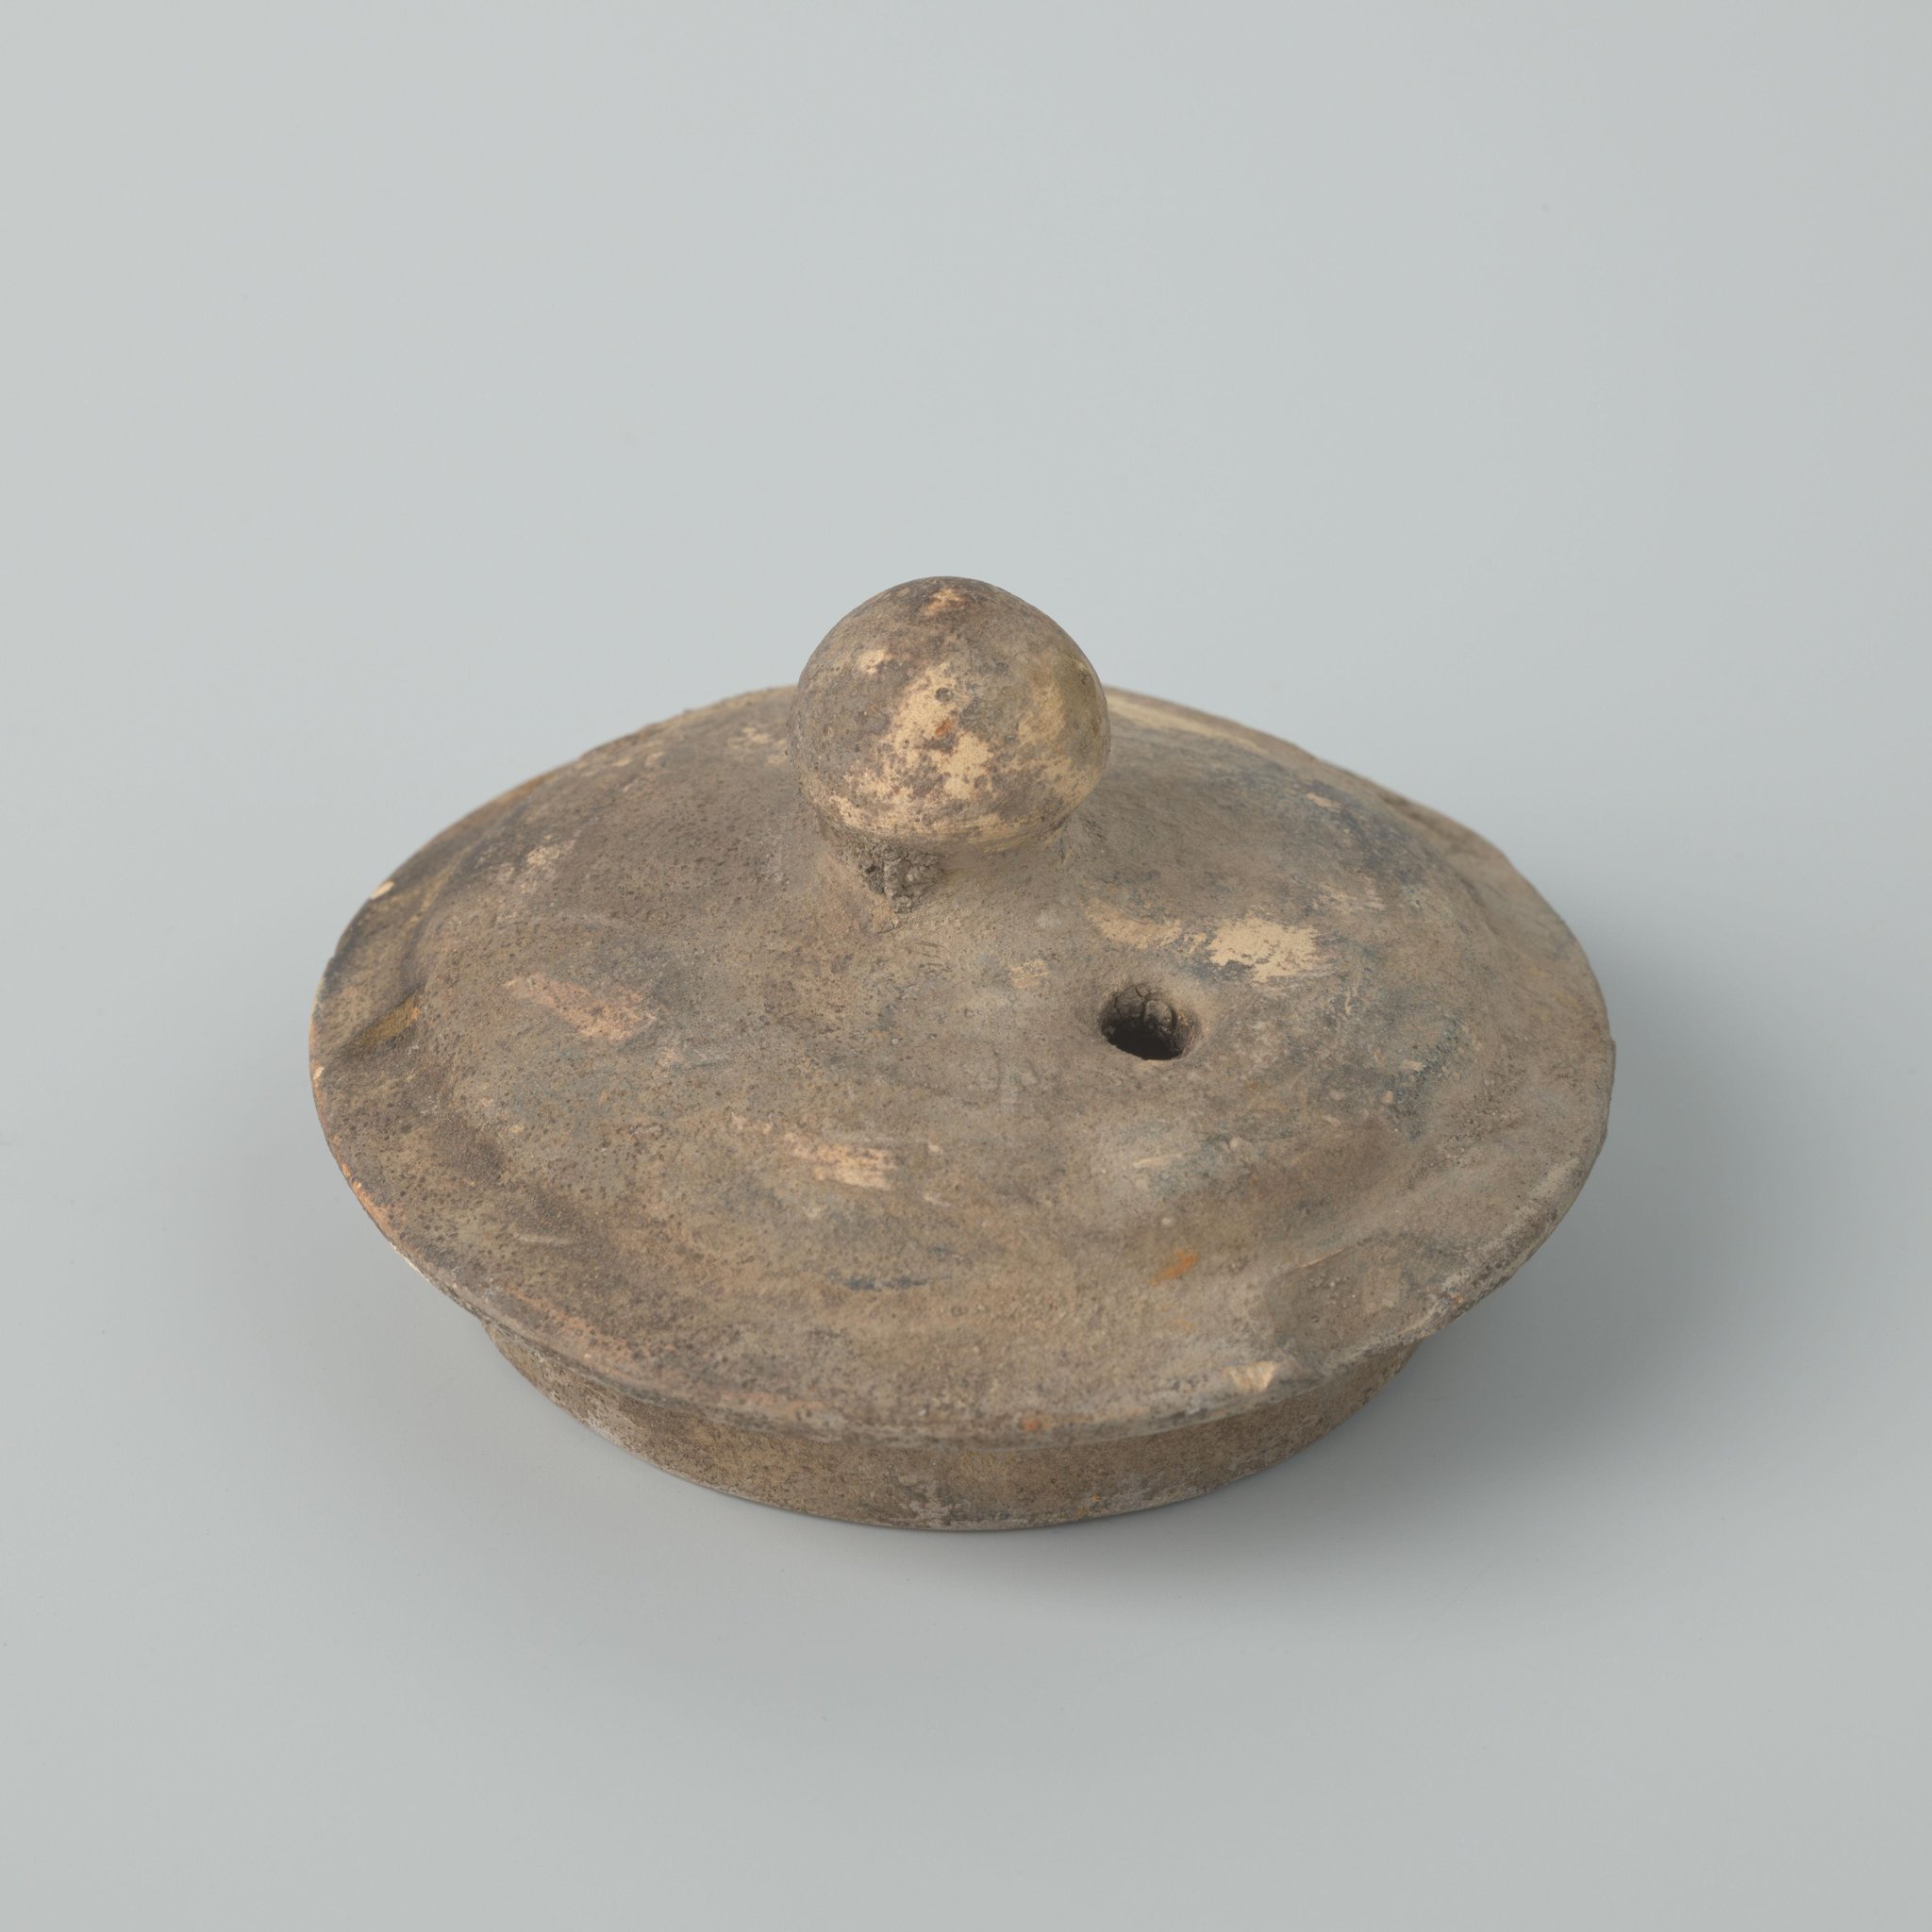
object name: lid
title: Deksel van een theepot (De Caluwe bakafval)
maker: jacobus de caluwe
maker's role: plateelbakkerij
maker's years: -1730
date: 1700-1725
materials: earthenware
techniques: firing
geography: delft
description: Toegeschreven aan Jacobus de Caluwe, omdat dit voorwerp samen met gemerkte stukken (‘Jacobus De Caluwe’ en rennend hert) gevonden is op de plaats waar zich De Caluwes tweede werkplaats bevond. Er is een duidelijke stilistische overeenkomst tussen de gemerkte en niet gemerkte voorwerpen uit deze archeologische vondst.